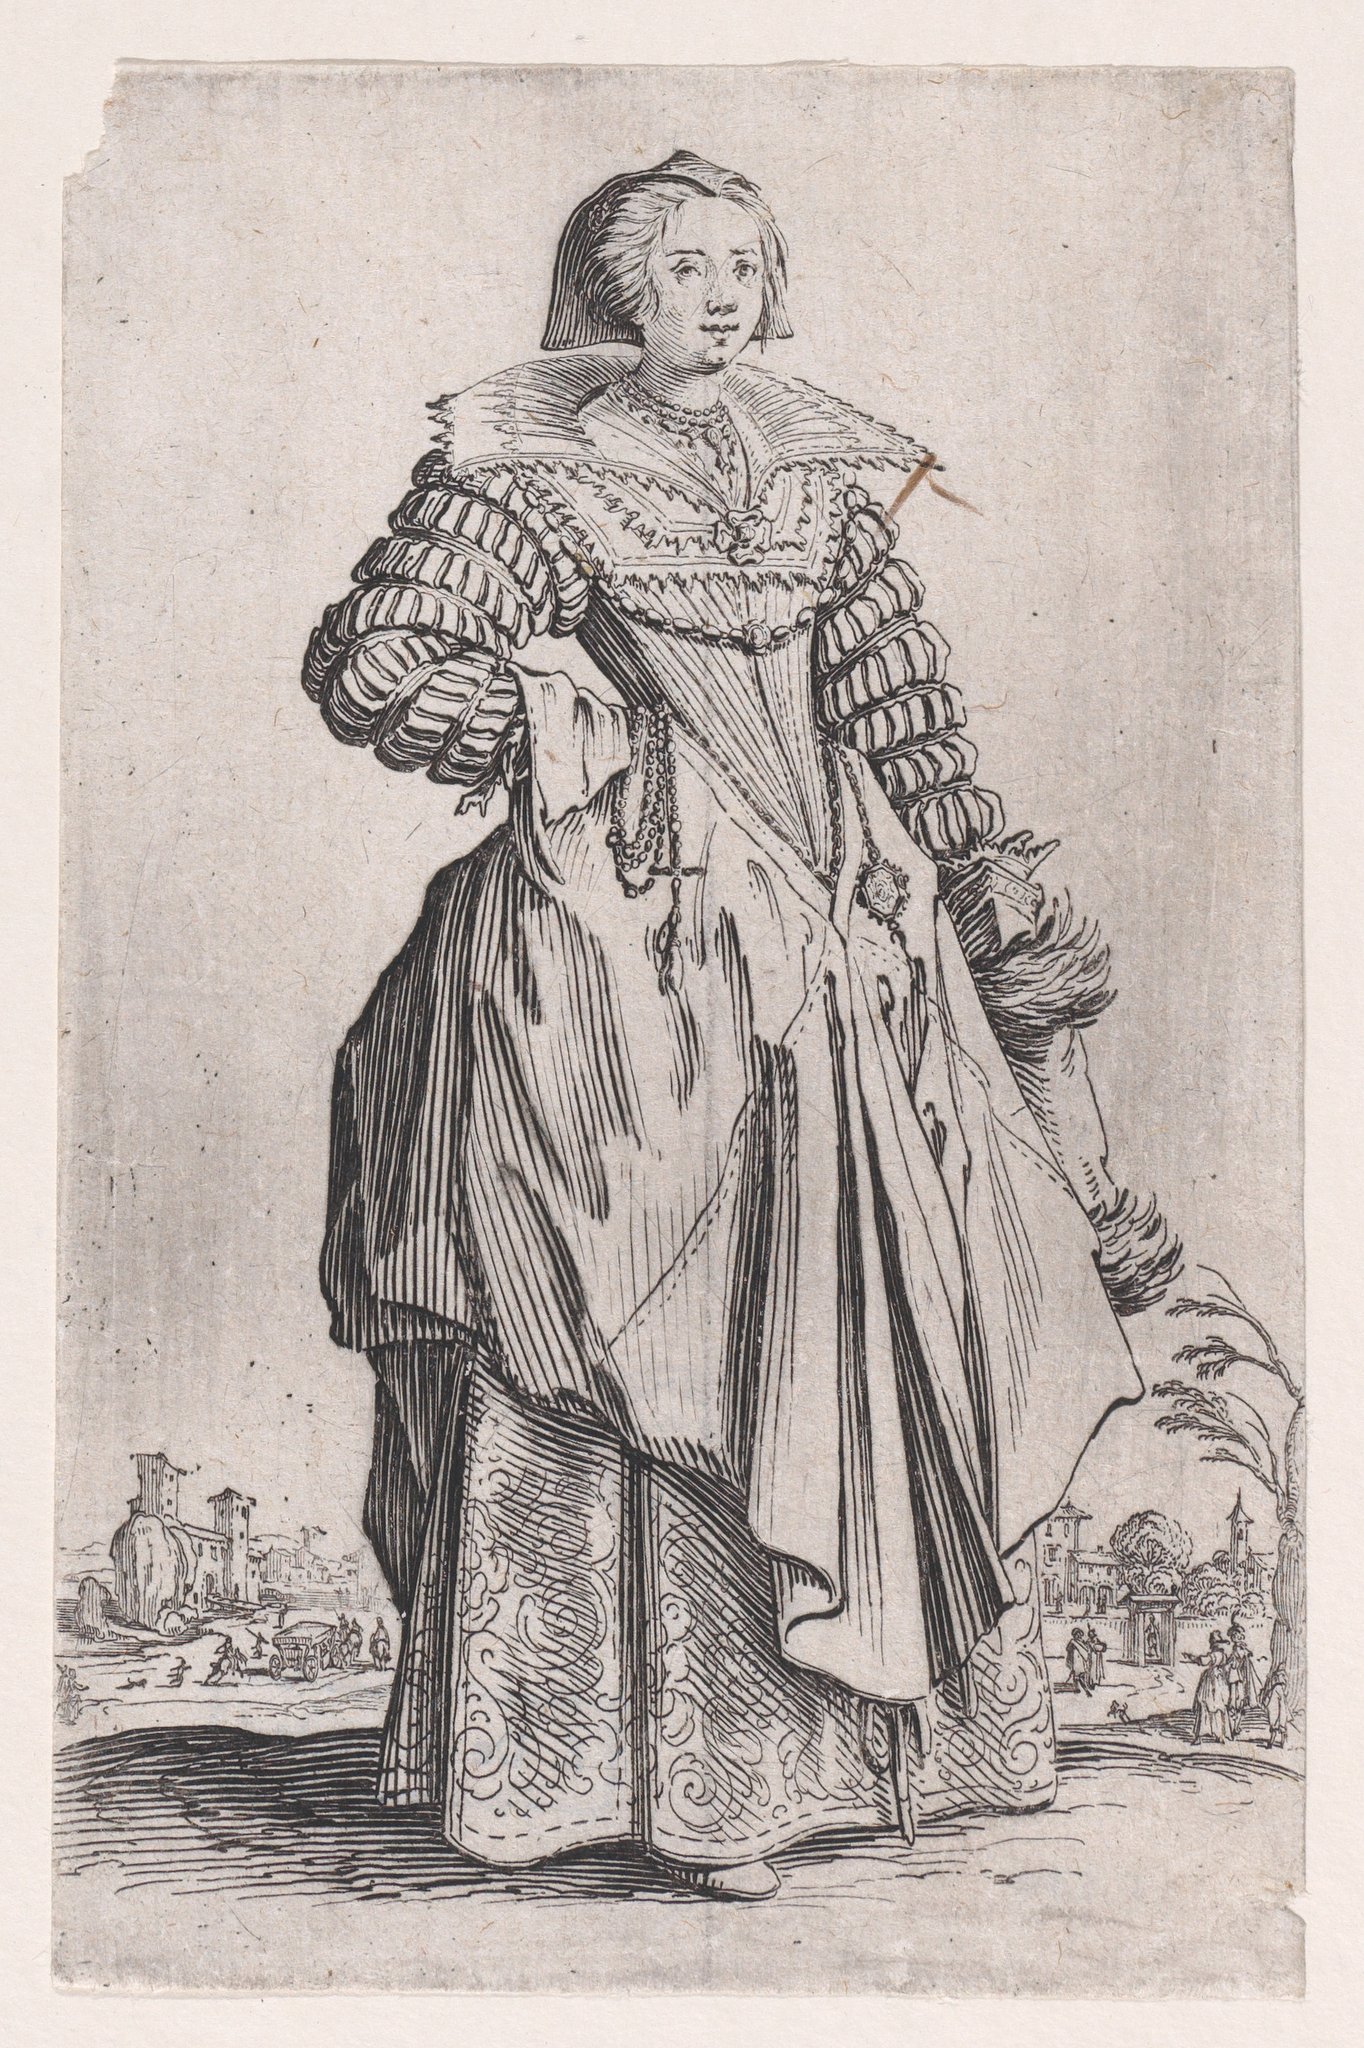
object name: print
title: La Dame a la Grande Collerette et a la Coiffe Retombant en Arrière (The Lady with the Large Collar and a Headdress that Falls to the Back), from "La Noblesse" (The Nobility)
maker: jacques callot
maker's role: artist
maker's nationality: french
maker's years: 1592-1635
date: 1623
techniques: etching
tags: women